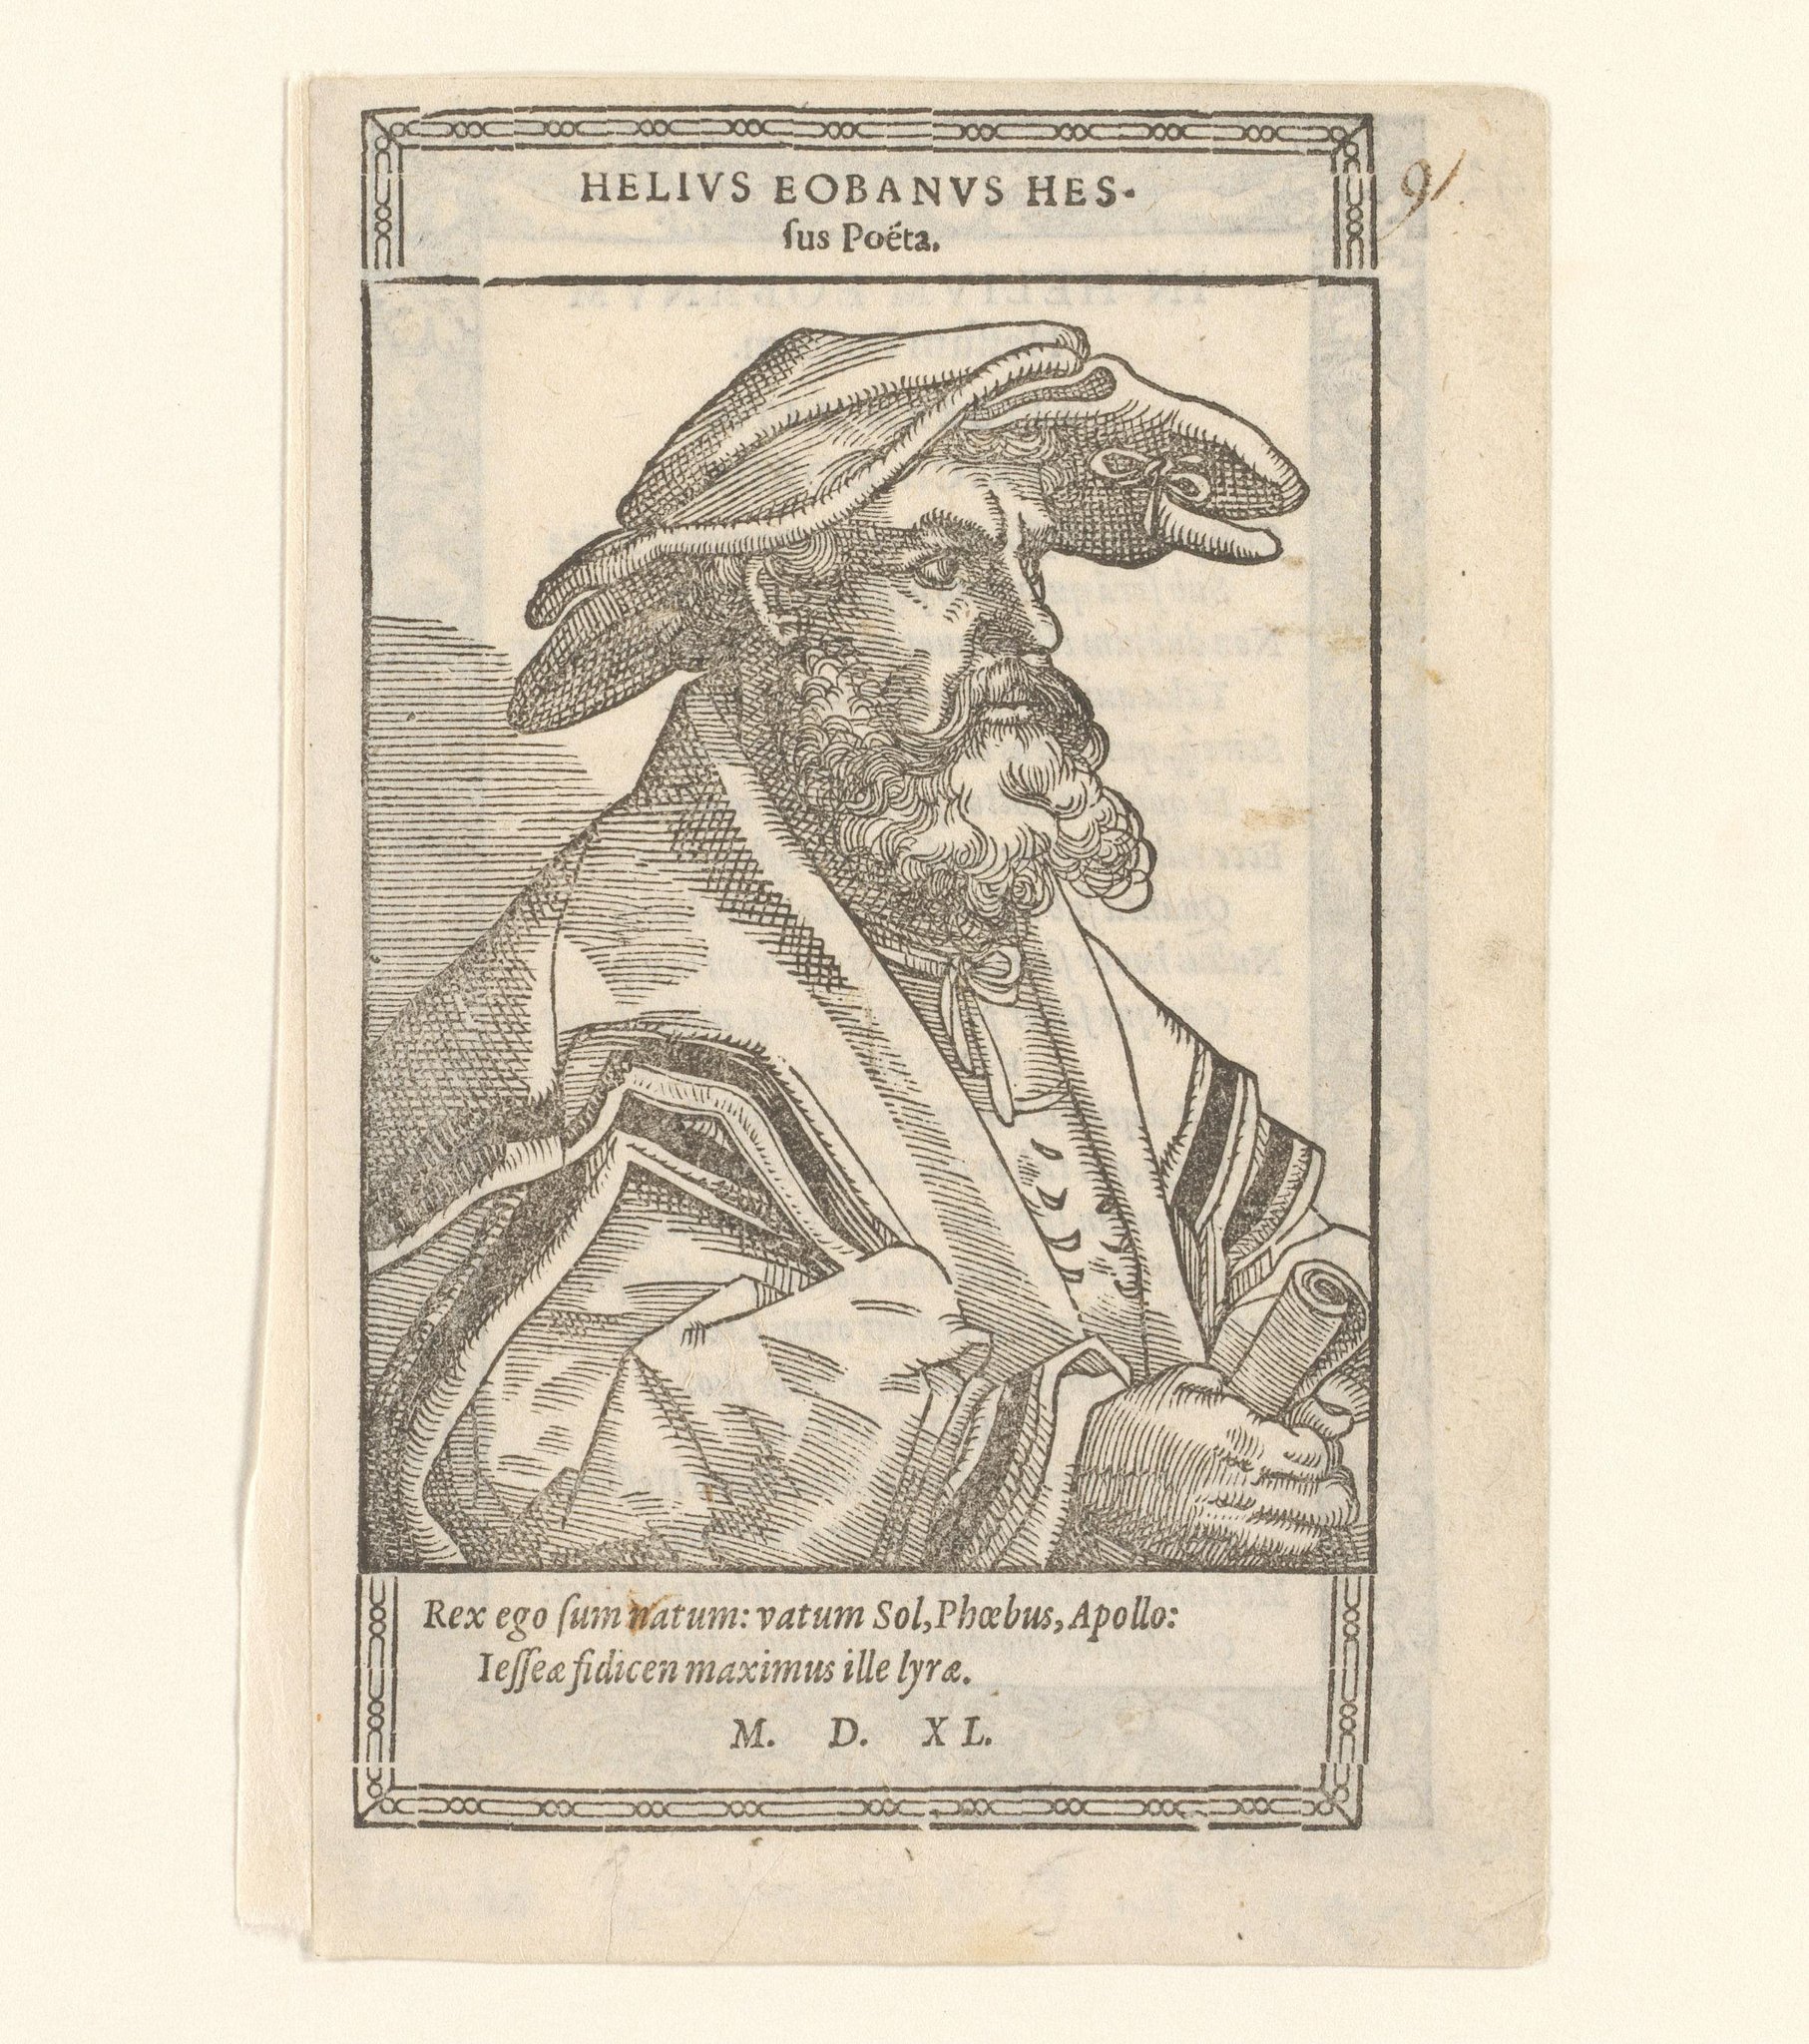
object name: book illustration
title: Portret van Helius Eobanus Hessus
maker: bernhard jobin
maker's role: printer, publisher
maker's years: 1545-1593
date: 1587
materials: paper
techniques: letterpress printing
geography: straatsburg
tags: helius eobanus hessus, historical persons, writer, poet, author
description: Prent uit: Reusner, Nikolaus. Icones sive imagines virorum literis illustrium (...). Straatsburg: Bernhard Jobin, 1587. Prent ook gebruikt in de Duitse editie, uitgegeven in hetzelfde jaar, en de 1590-editie. Prent mogelijk ook gebruikt in latere publicaties.